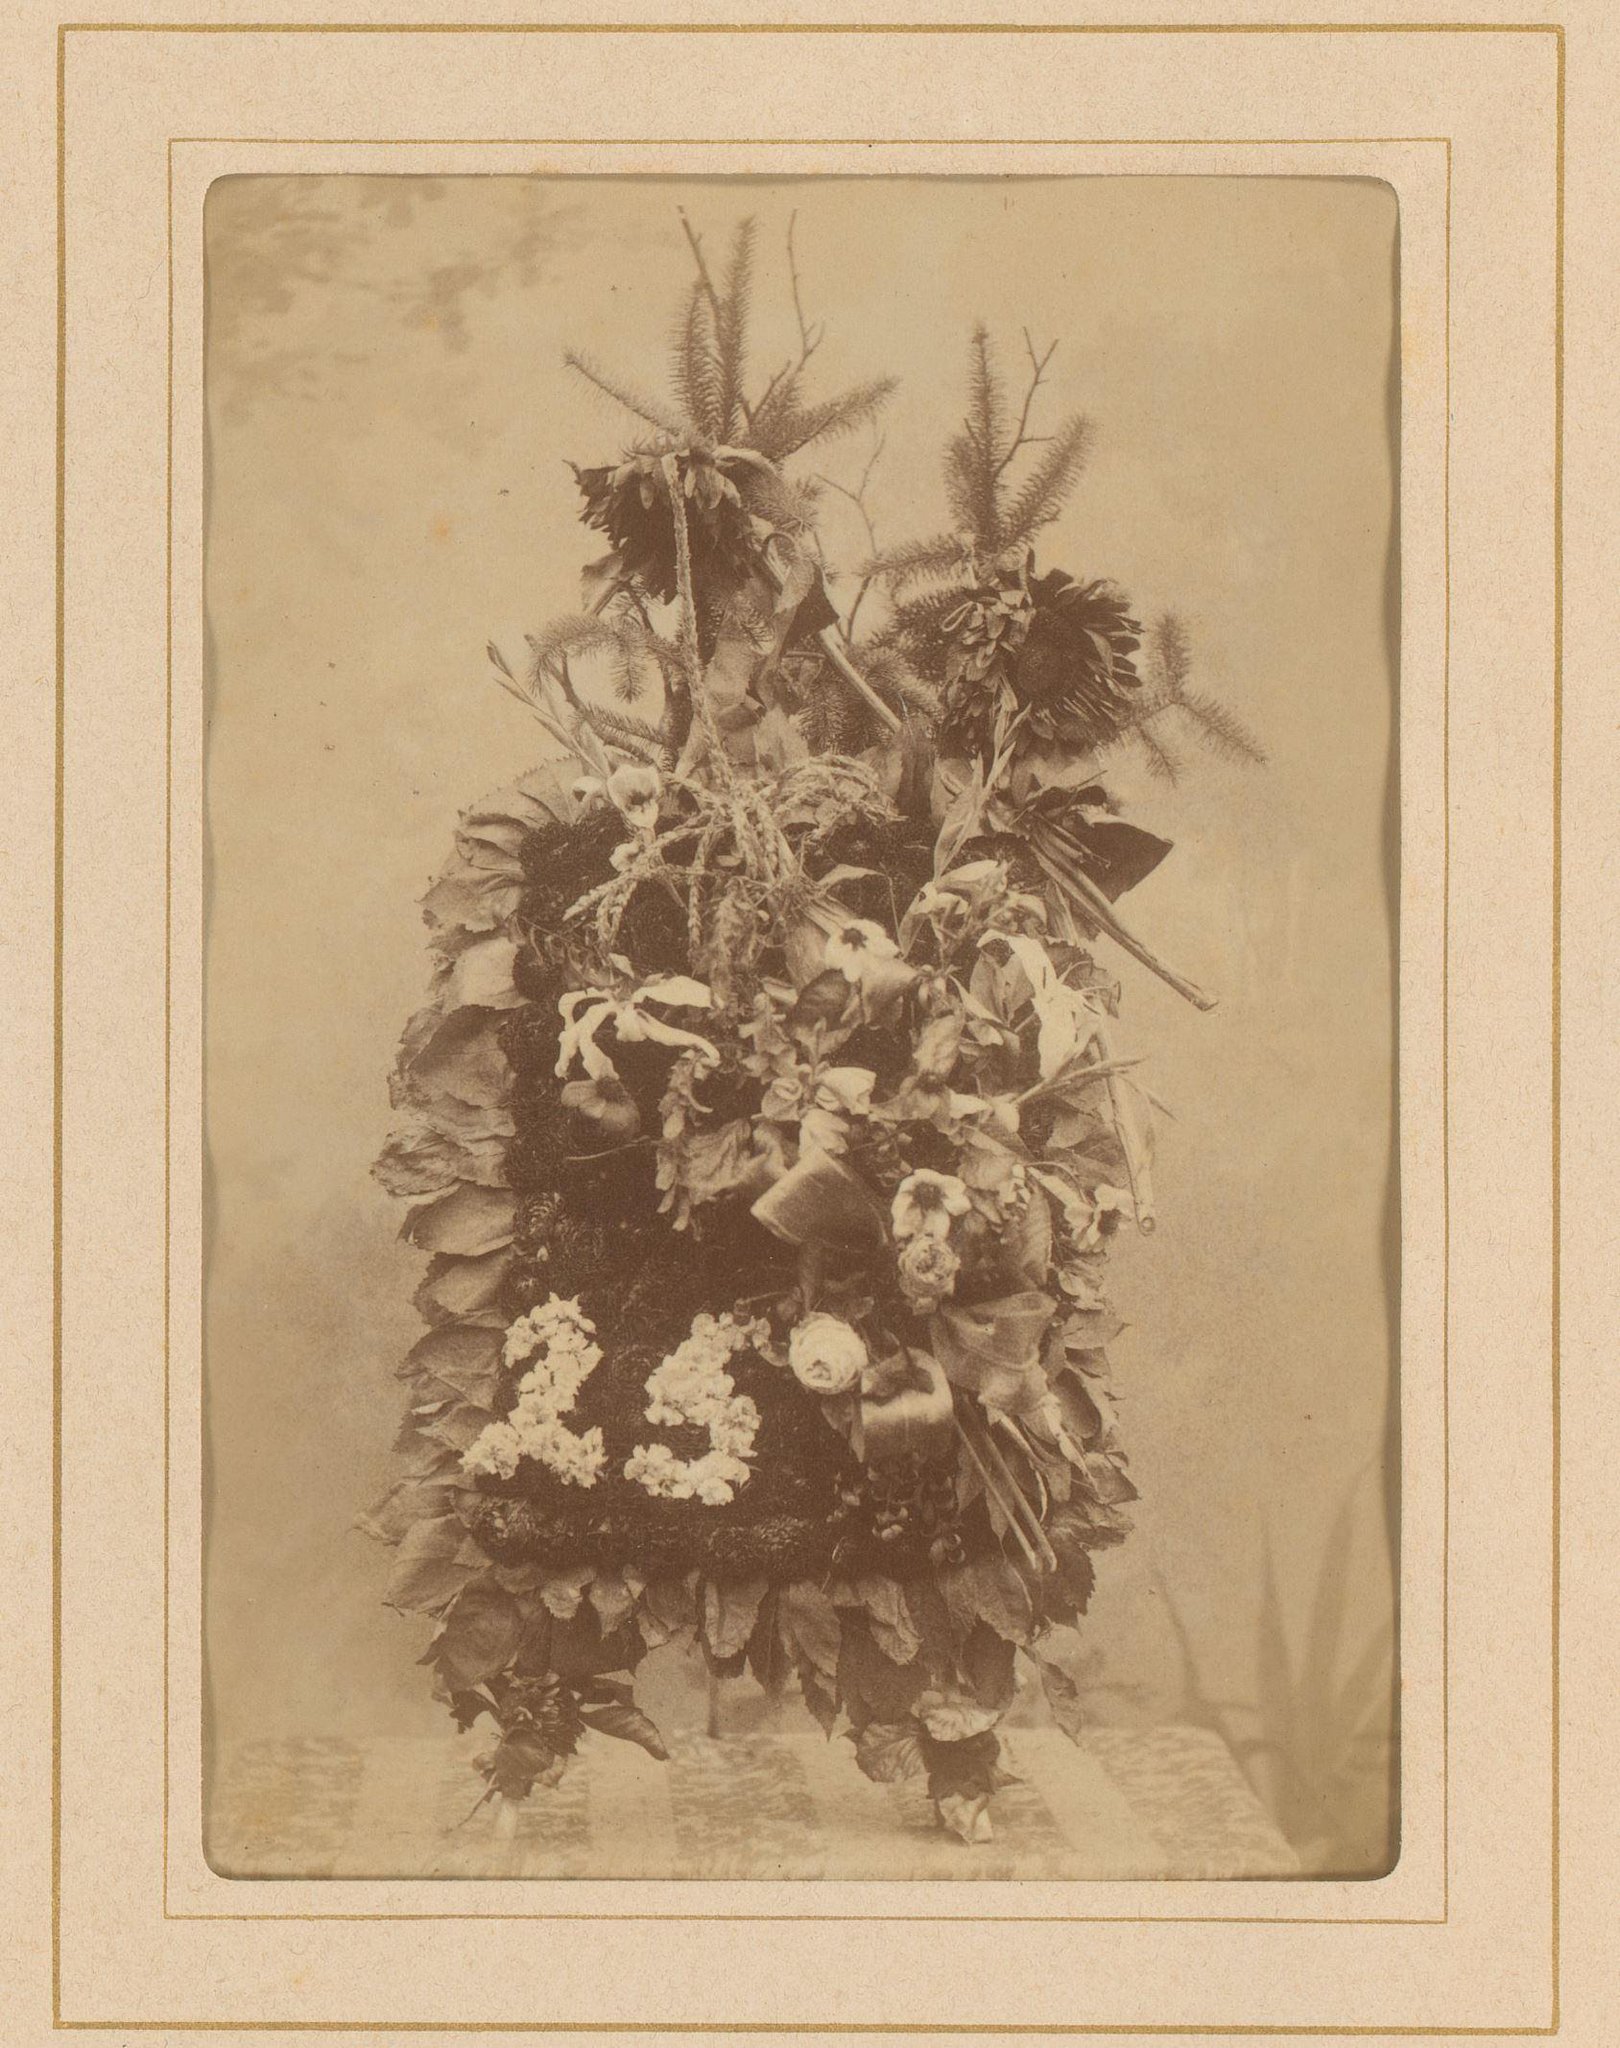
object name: cabinet photograph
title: Bloemstuk op tafel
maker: hendrikus franciscus kramer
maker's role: fotograaf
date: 1885-1900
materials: cardboard, photographic support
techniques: albumen print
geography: utrecht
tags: cut flowers; nosegay, bunch of flowers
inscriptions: inscription: ‘H.F. Kramer Janskerkhof No 8, Utrecht’